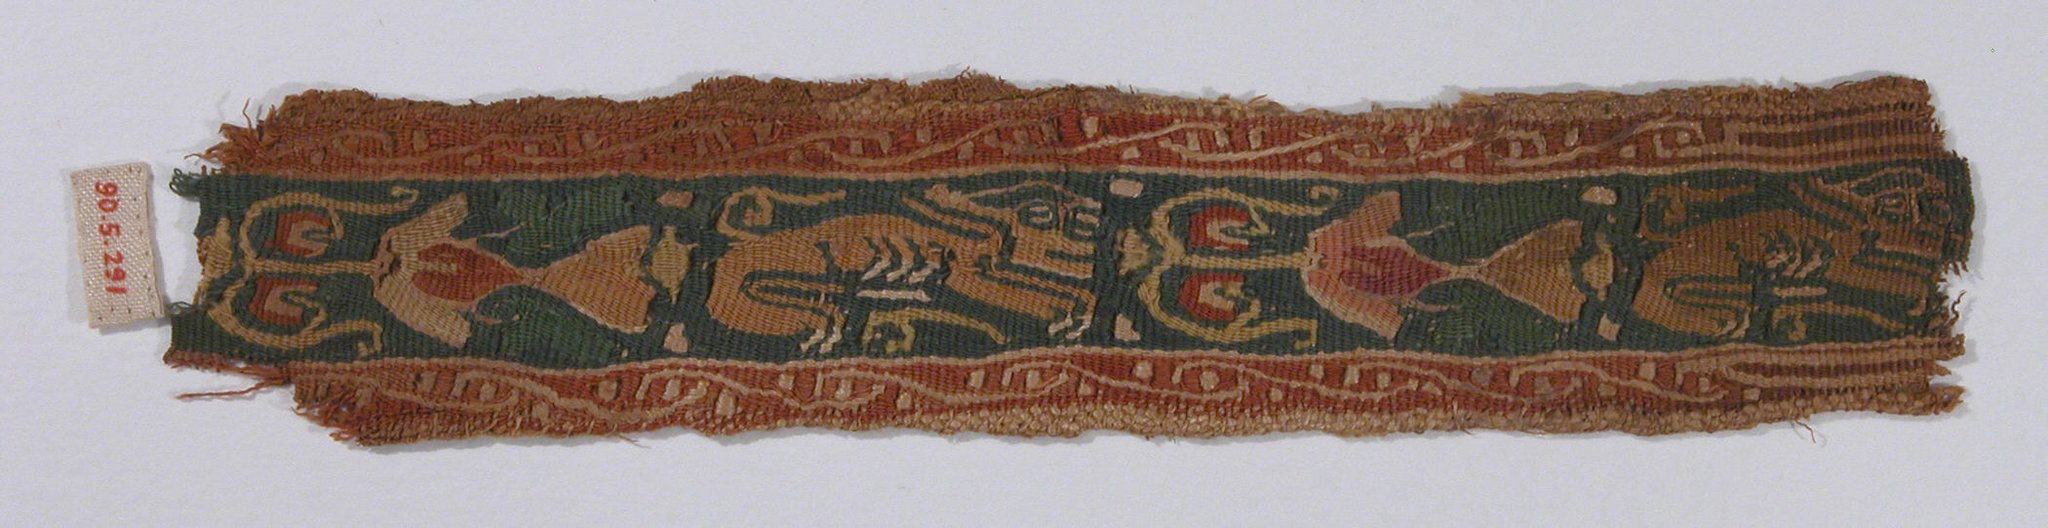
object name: textile fragment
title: Fragment of a Shoulder Band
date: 401-600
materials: linen, wool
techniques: weave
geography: egypt